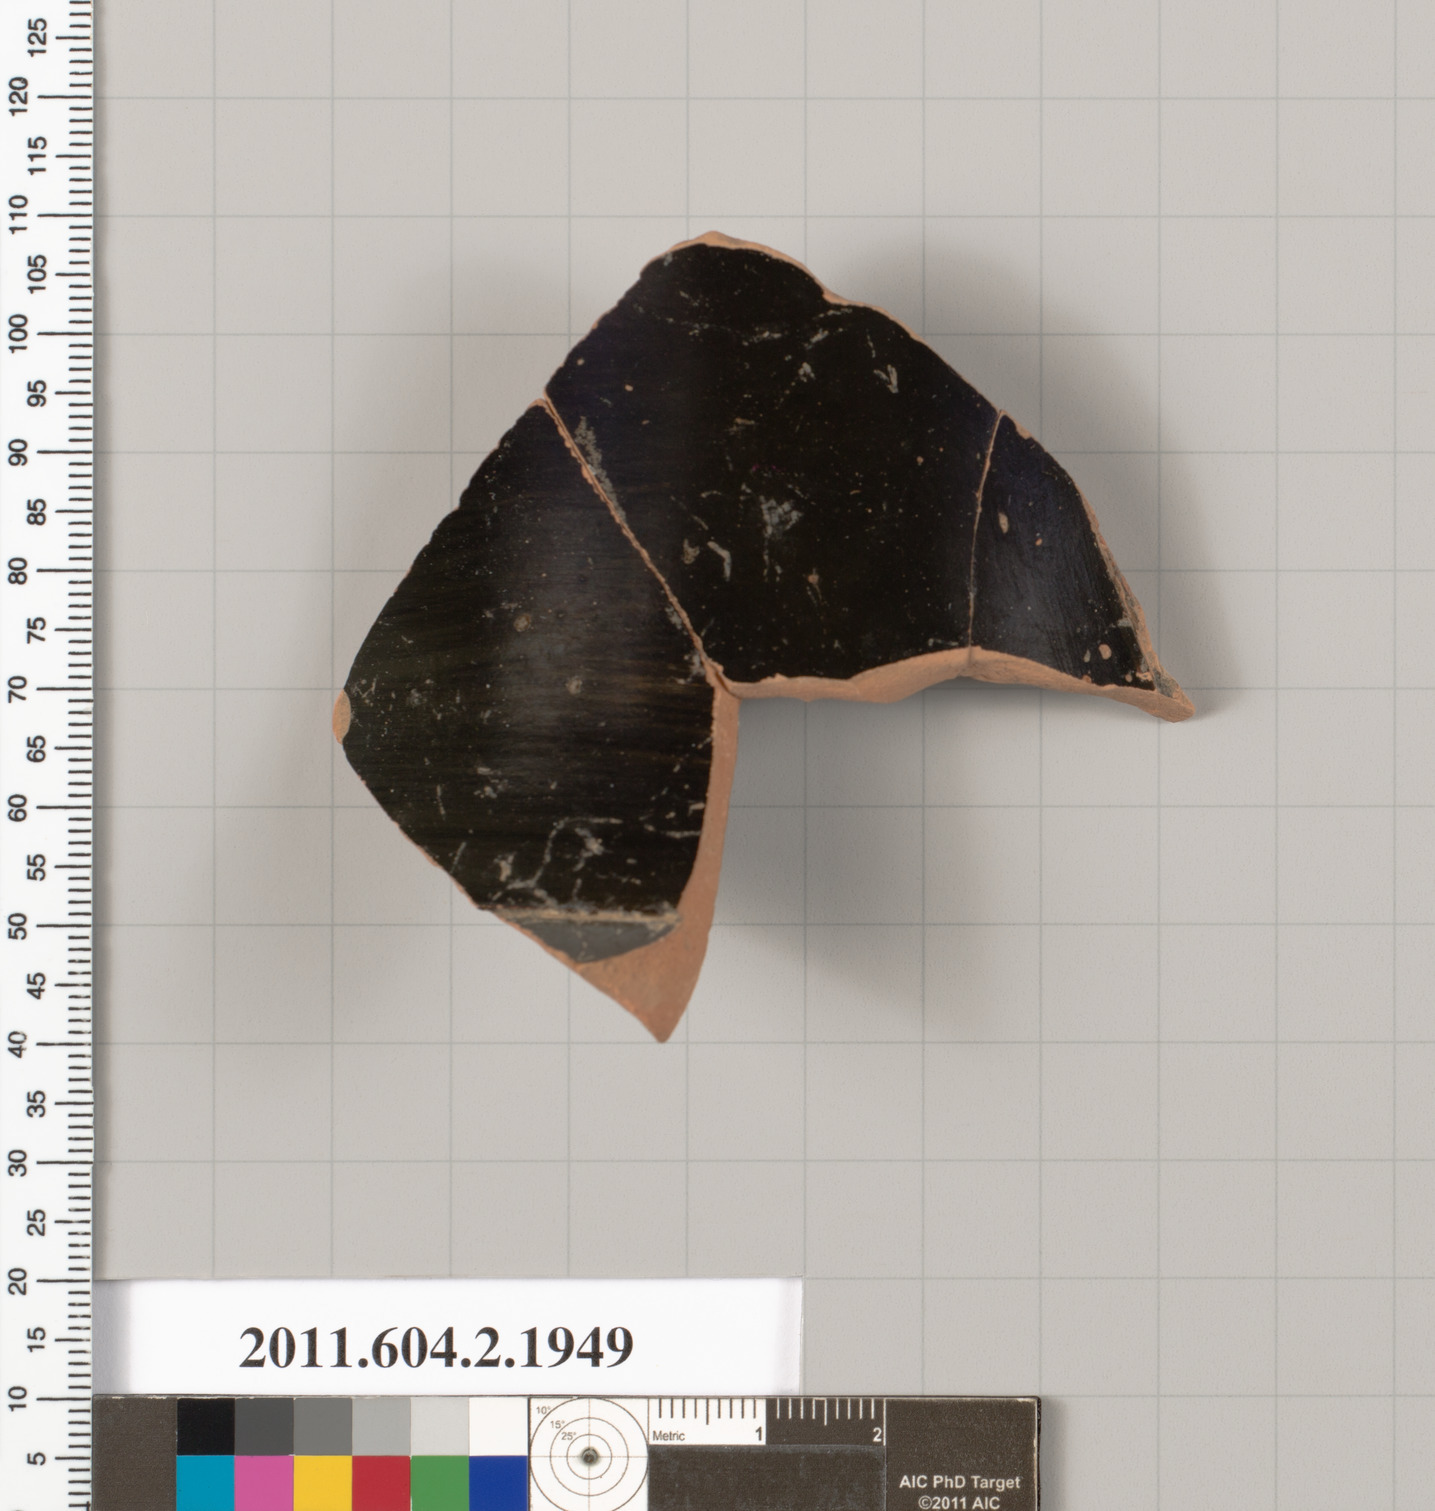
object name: neck amphora fragment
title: Terracotta fragment of a Nolan neck-amphora (jar)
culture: greek, attic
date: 475-460 BCE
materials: terracotta